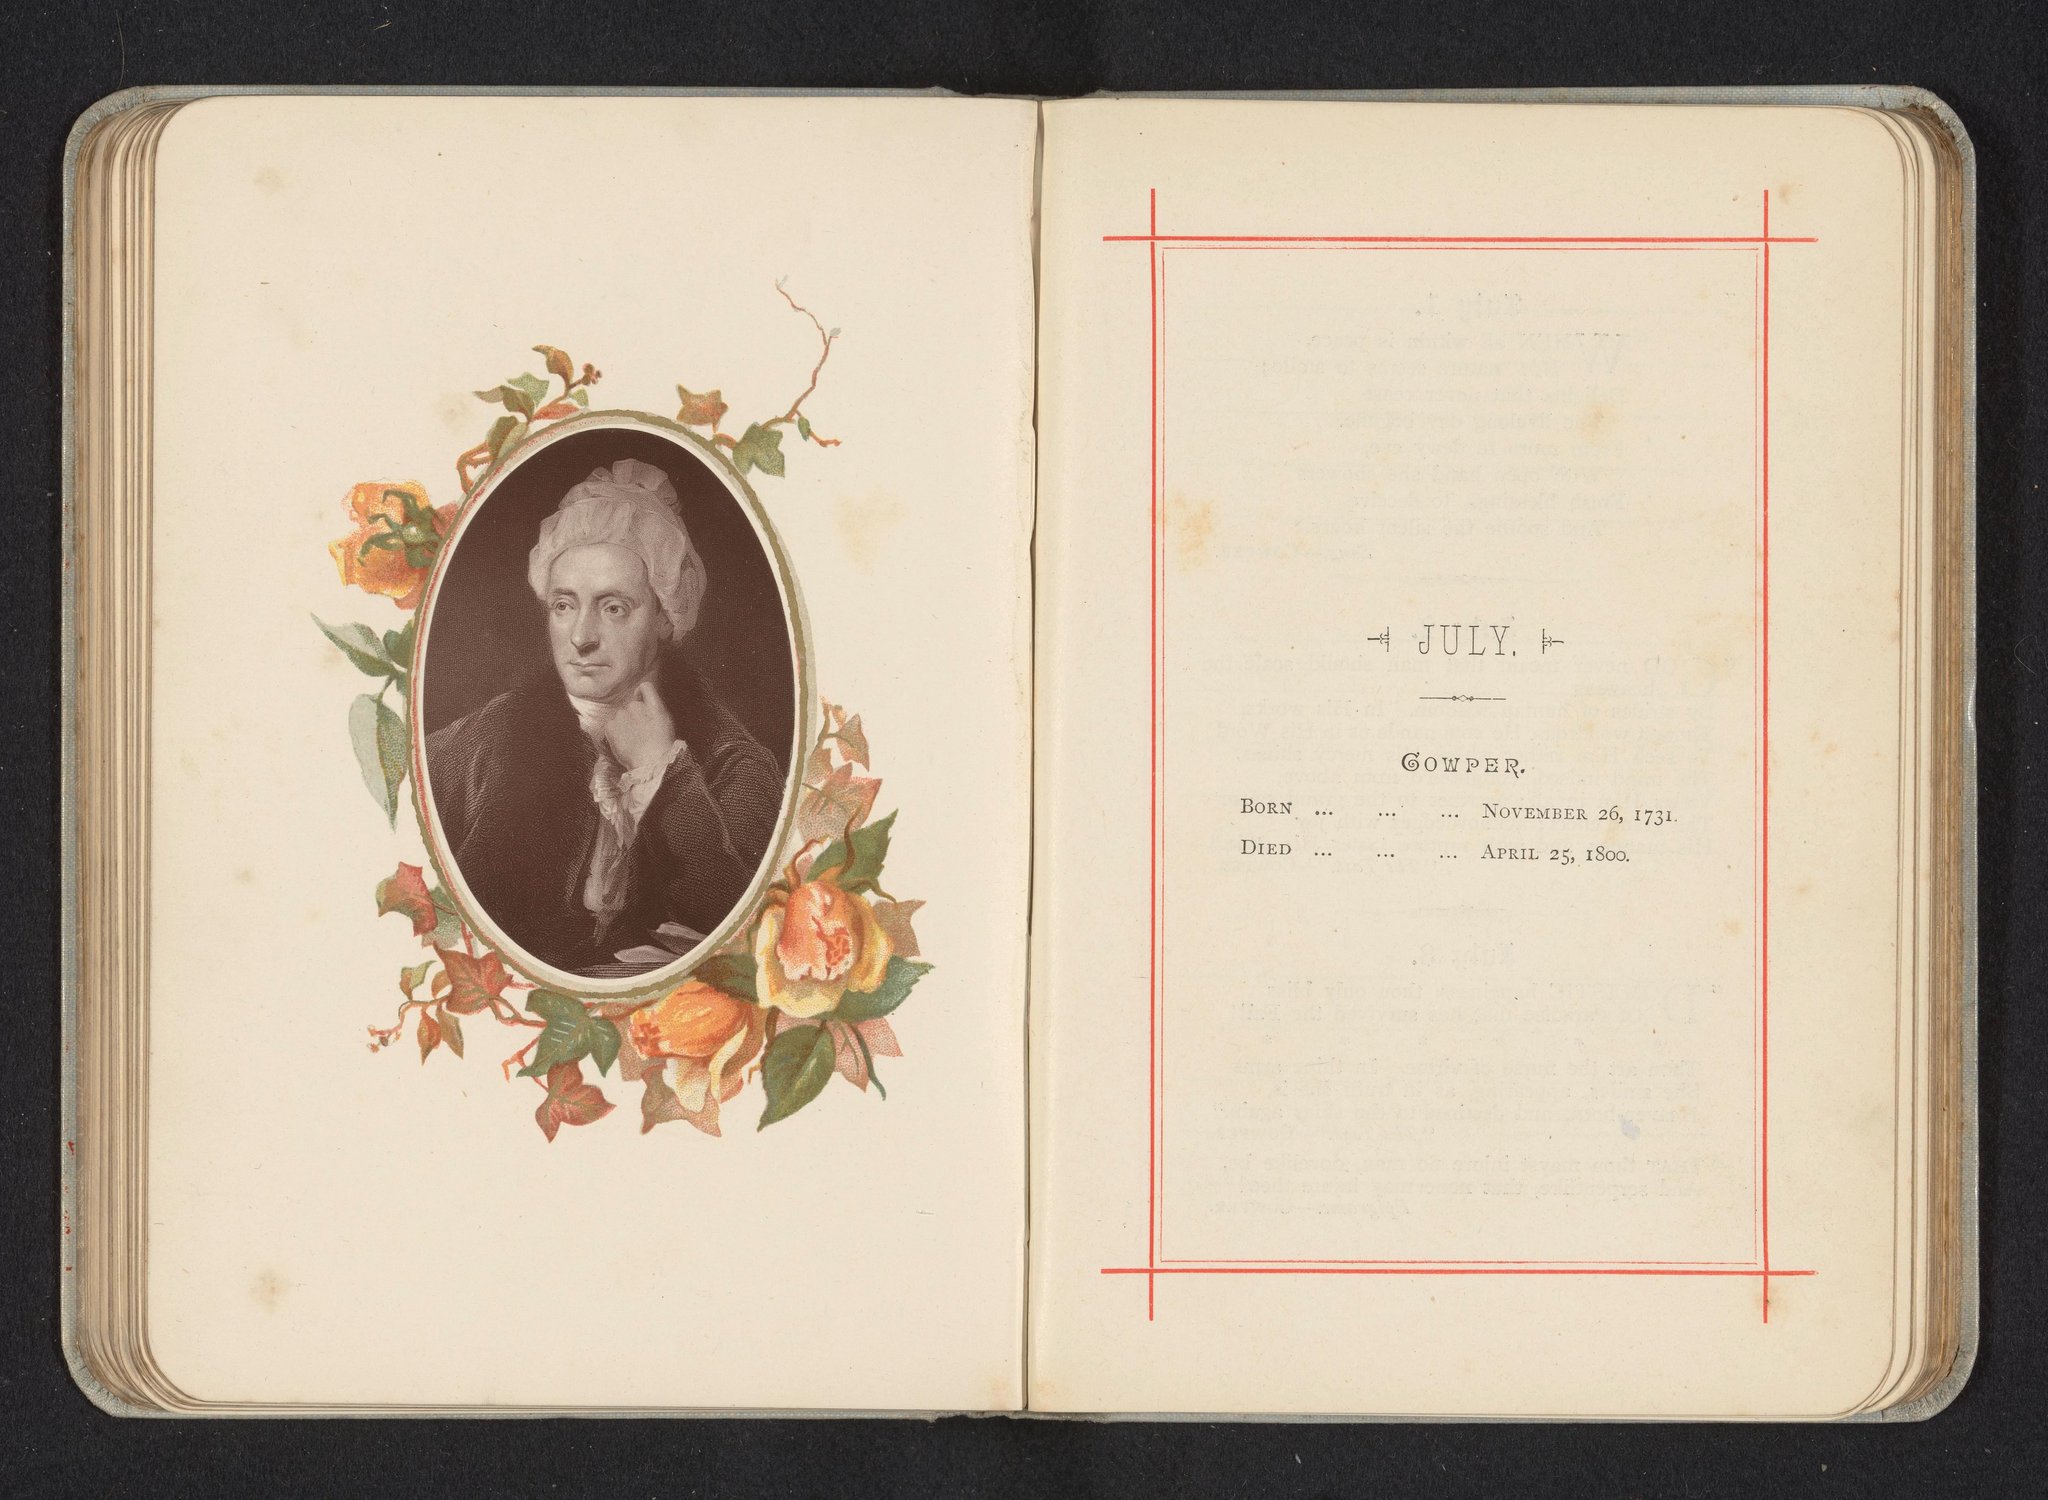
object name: photomechanical print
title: Fotoreproductie van een portret van William Cowper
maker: Anonymous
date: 1878-1888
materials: paper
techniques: woodburytype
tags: william cowper, writer, poet, author